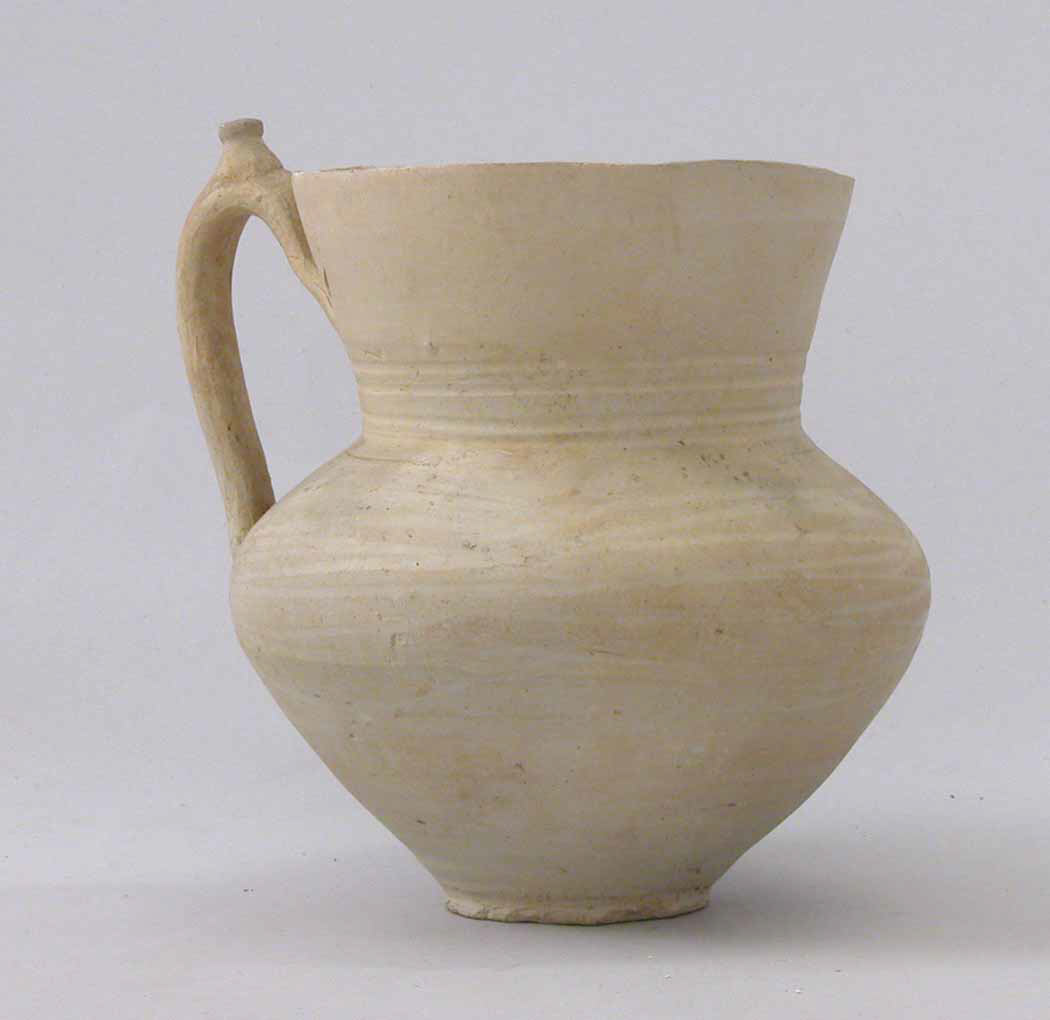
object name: jar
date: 801-1000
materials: earthenware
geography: iran